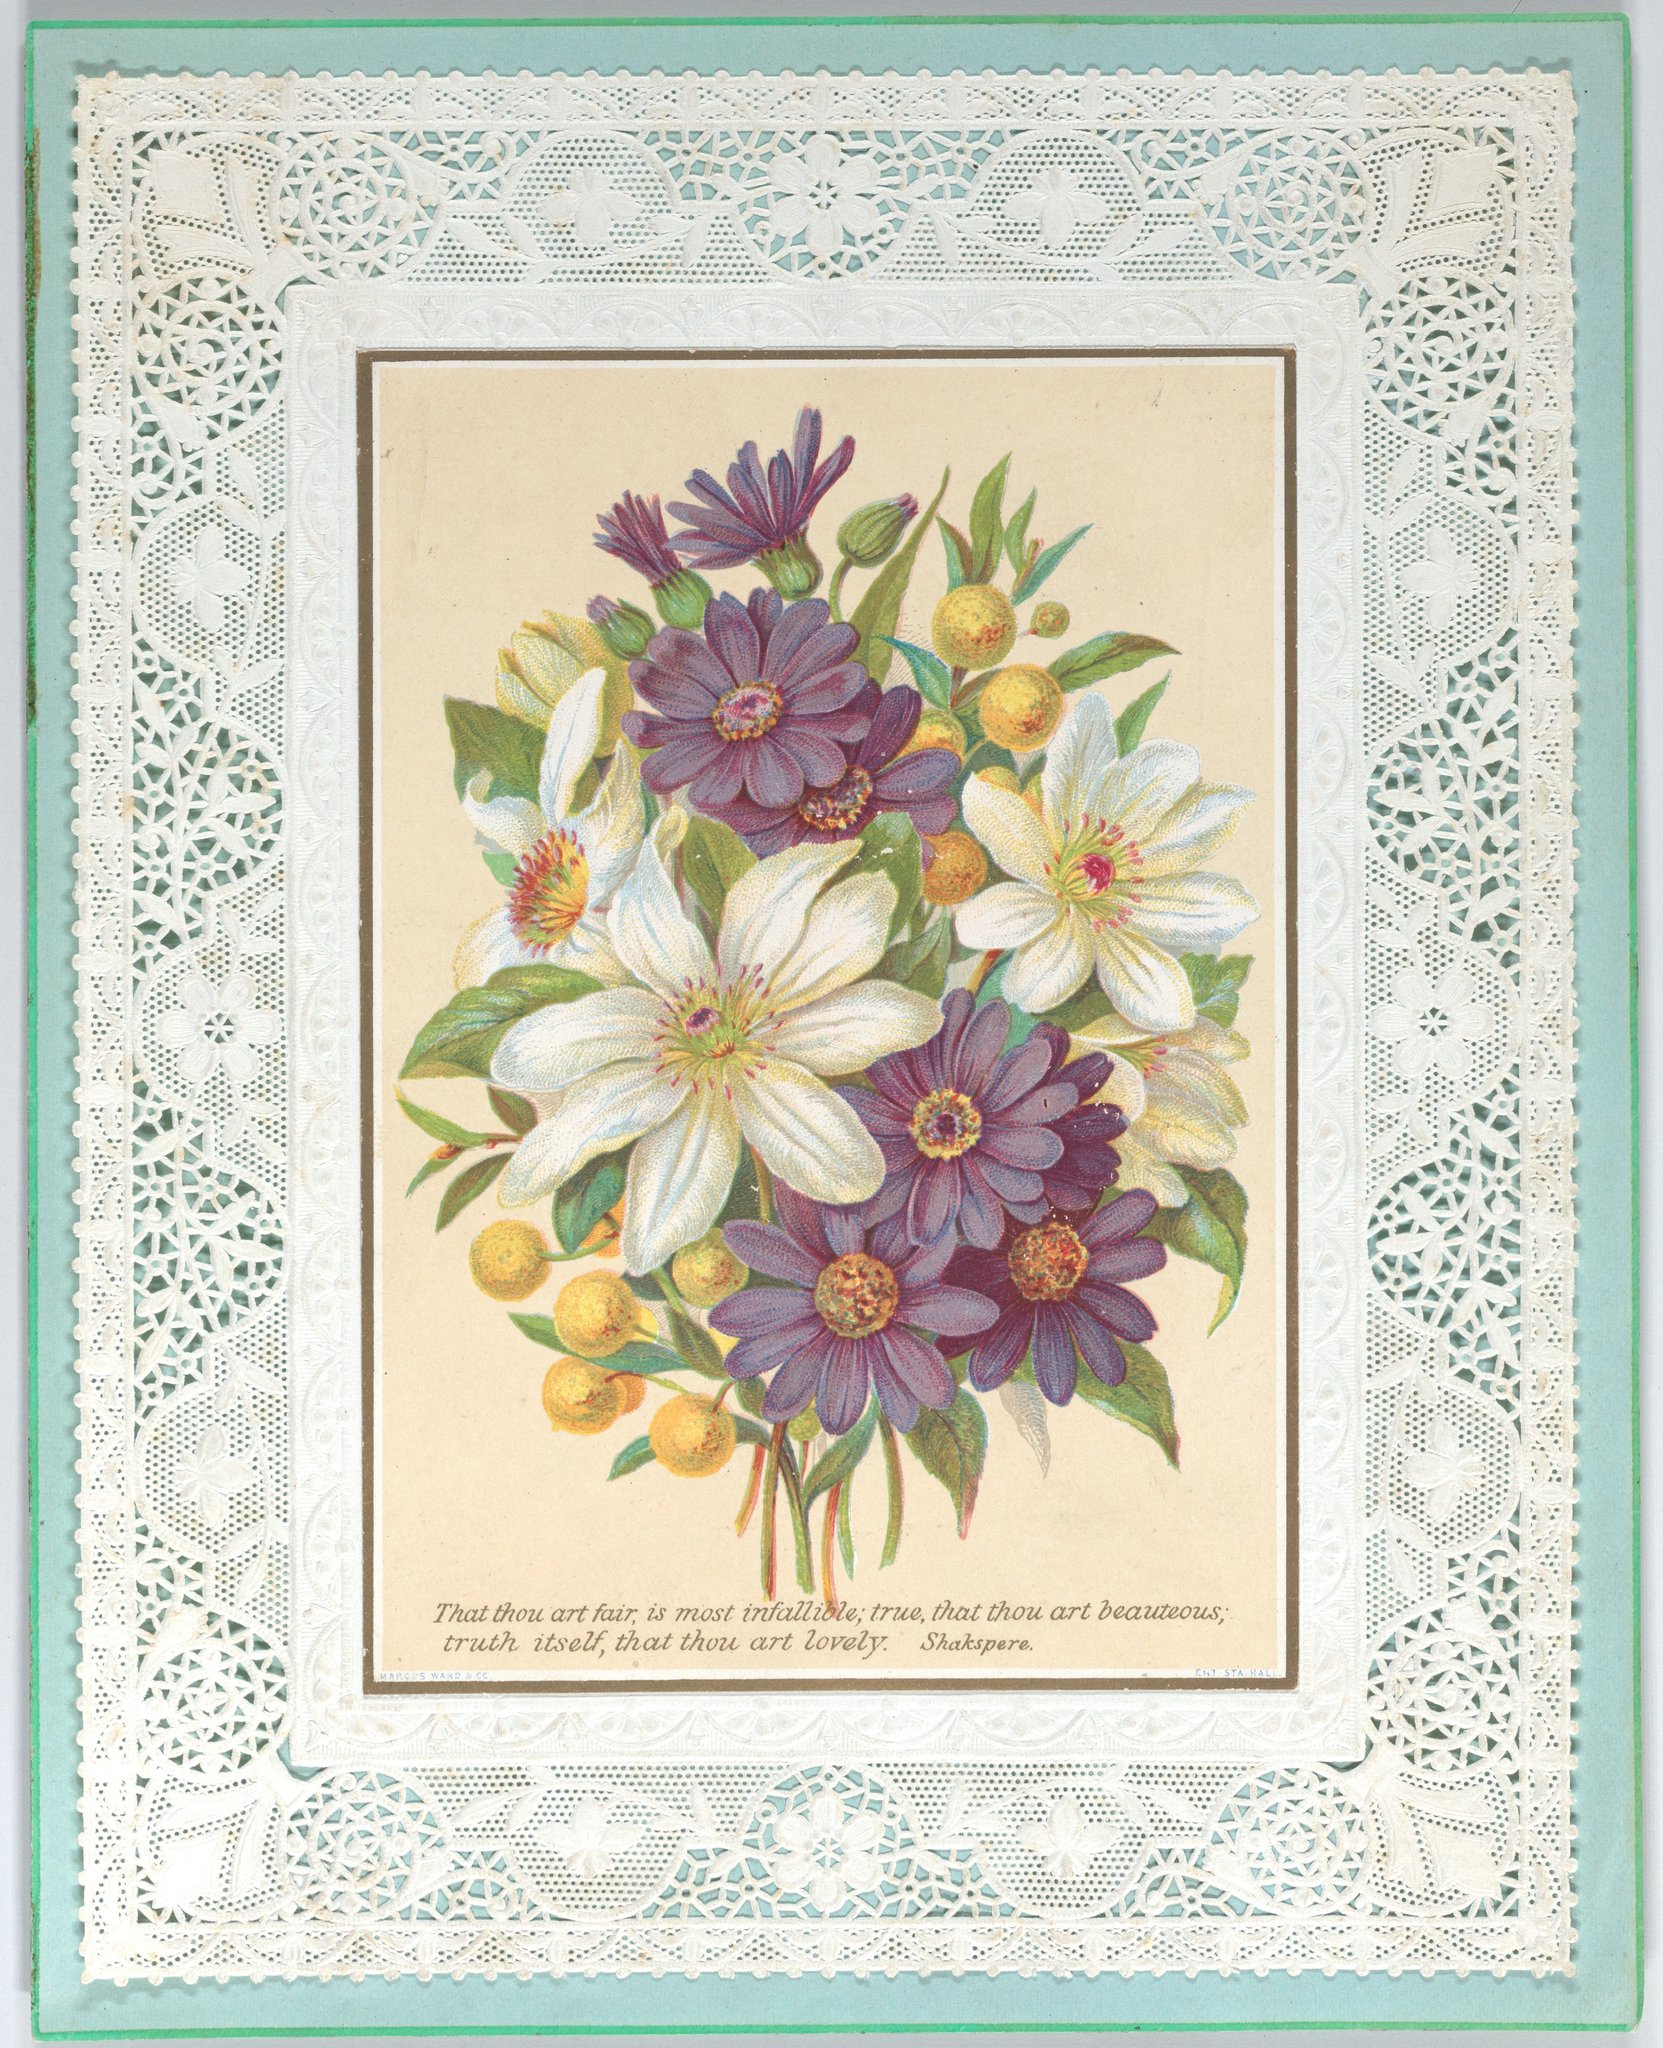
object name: valentine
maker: Anonymous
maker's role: artist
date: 1876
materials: gold, lace, paper, watercolor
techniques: chromolithography, lithograph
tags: flowers